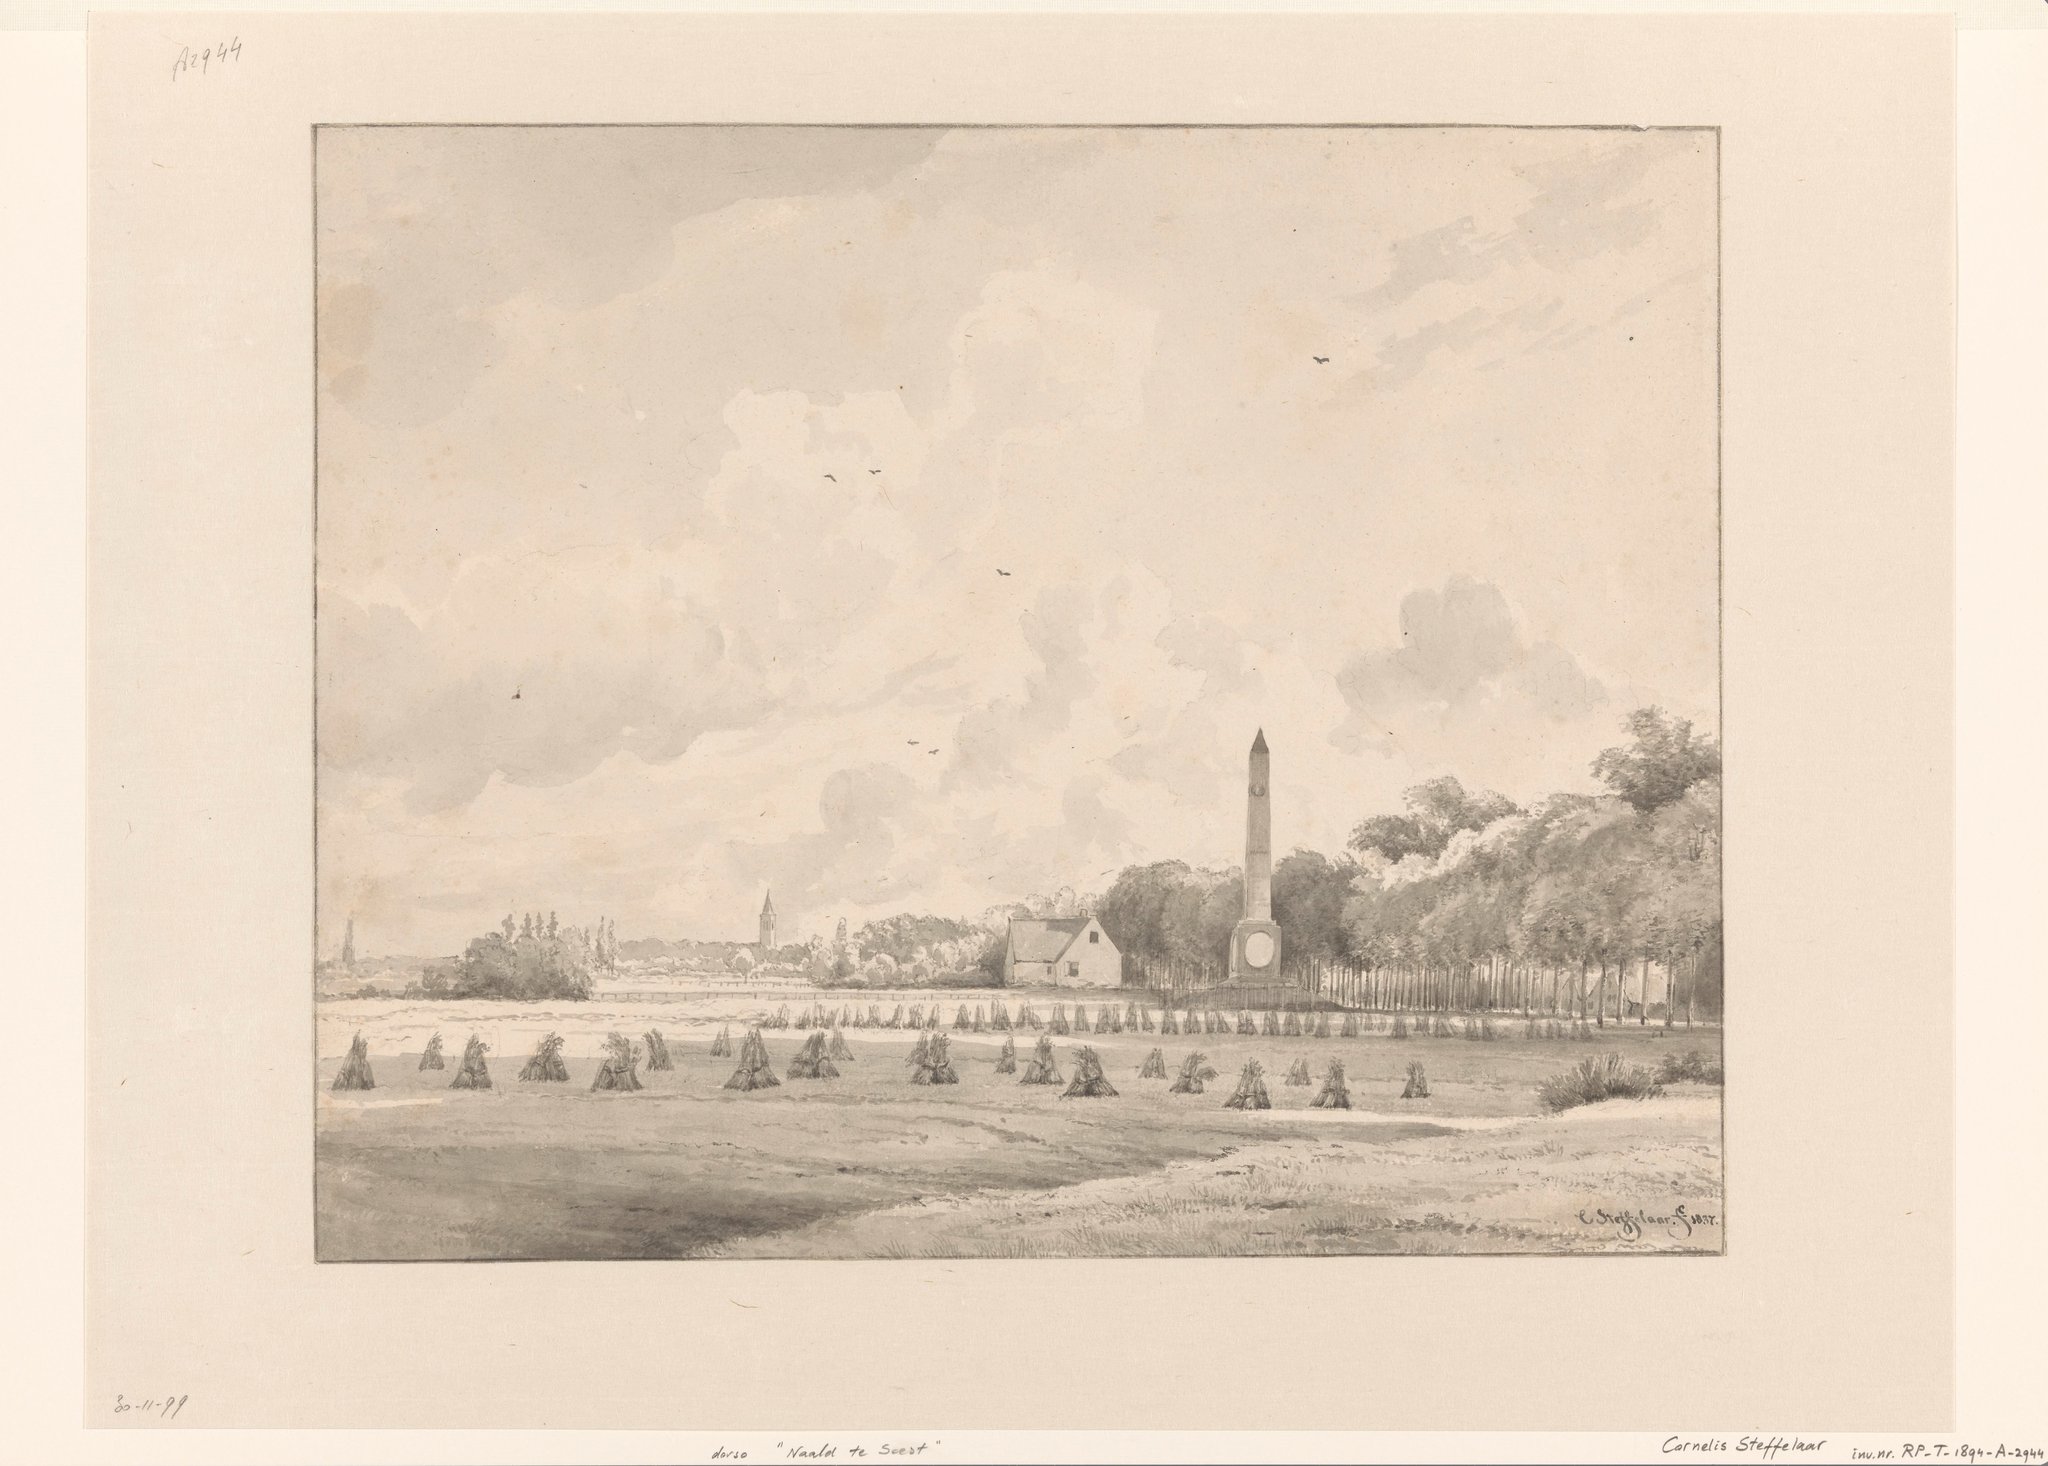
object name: drawing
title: Korenveld met de Naald te Soestdijk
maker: cornelis steffelaar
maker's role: draughtsman, painter, print maker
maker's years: 1797-1861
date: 1837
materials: chalk, paper, pencil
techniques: brush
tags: landscape with monument, cultivated land, monument, statue, cereal, grain, corn (grass with grains, grown for food, e.g.: wheat, rice, rye, oats, maize, buckwheat, millet)